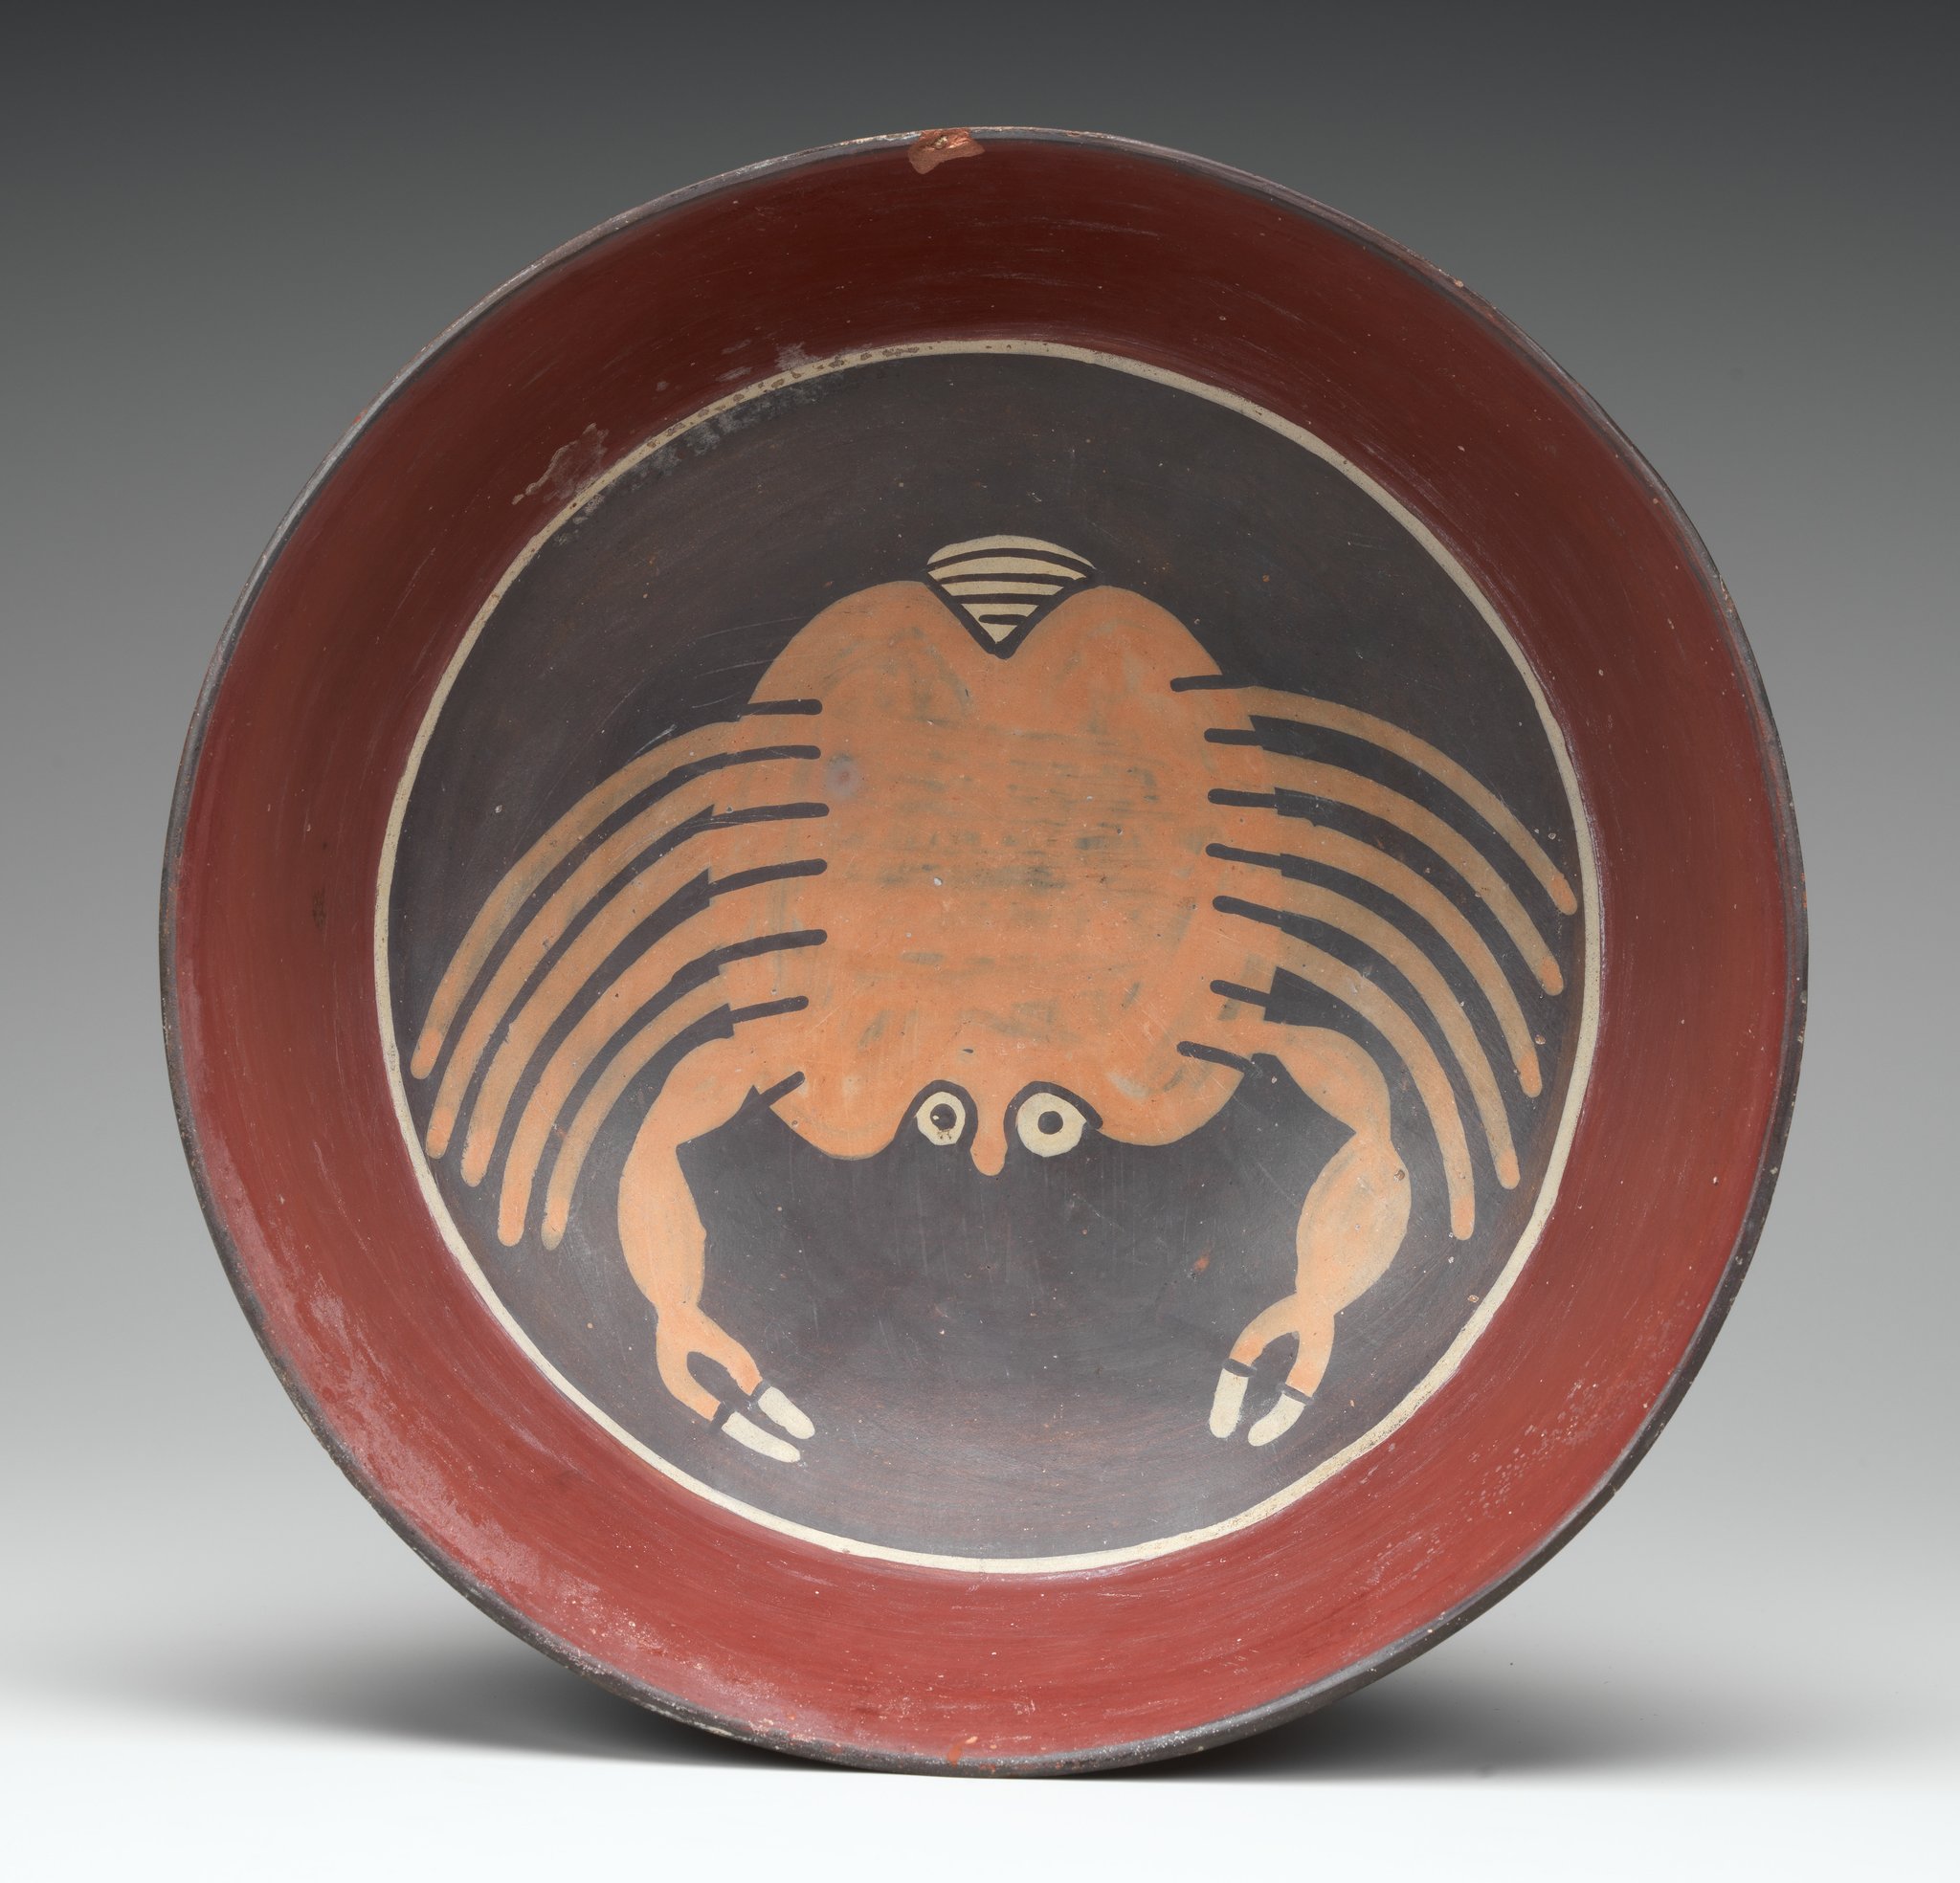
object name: bowl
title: Bowl: Crab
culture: nasca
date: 101-400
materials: ceramic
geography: peru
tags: crabs